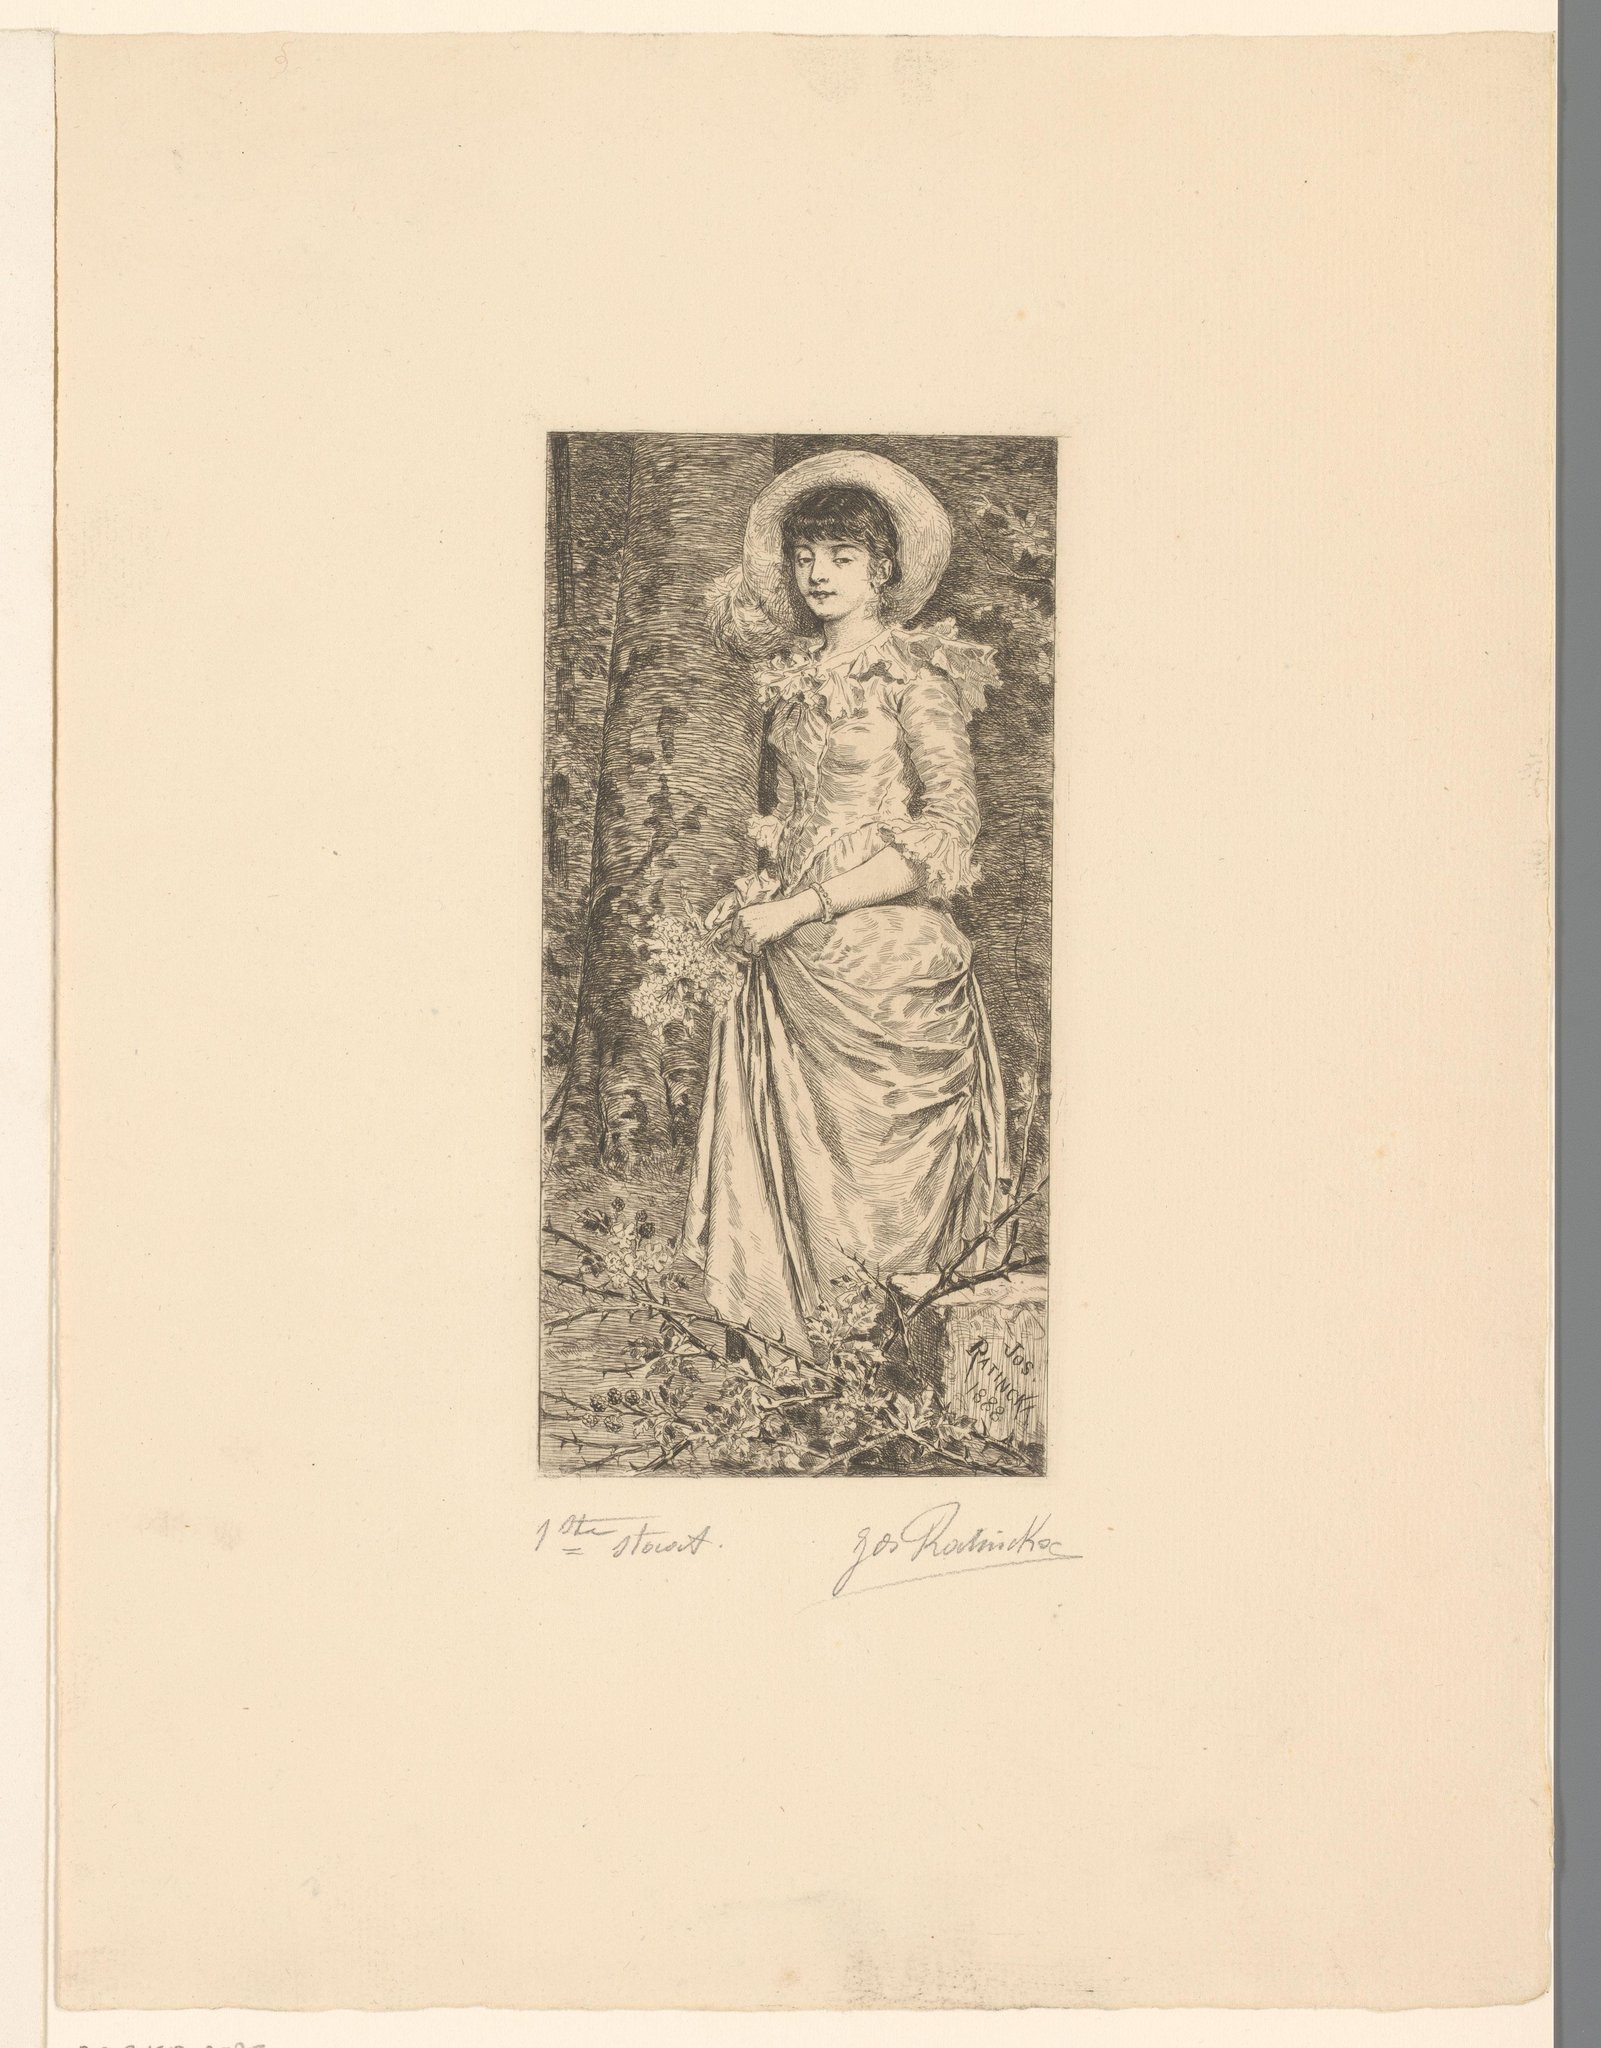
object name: print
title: Jonge vrouw in een bos met bloemen in haar hand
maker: jos ratinckx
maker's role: print maker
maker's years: 1860-1937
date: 1888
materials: paper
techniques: etching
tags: flowers, adolescent, young woman, maiden, forest, wood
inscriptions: inscription: ‘1ste staat’, collector's mark: Lugt 2228